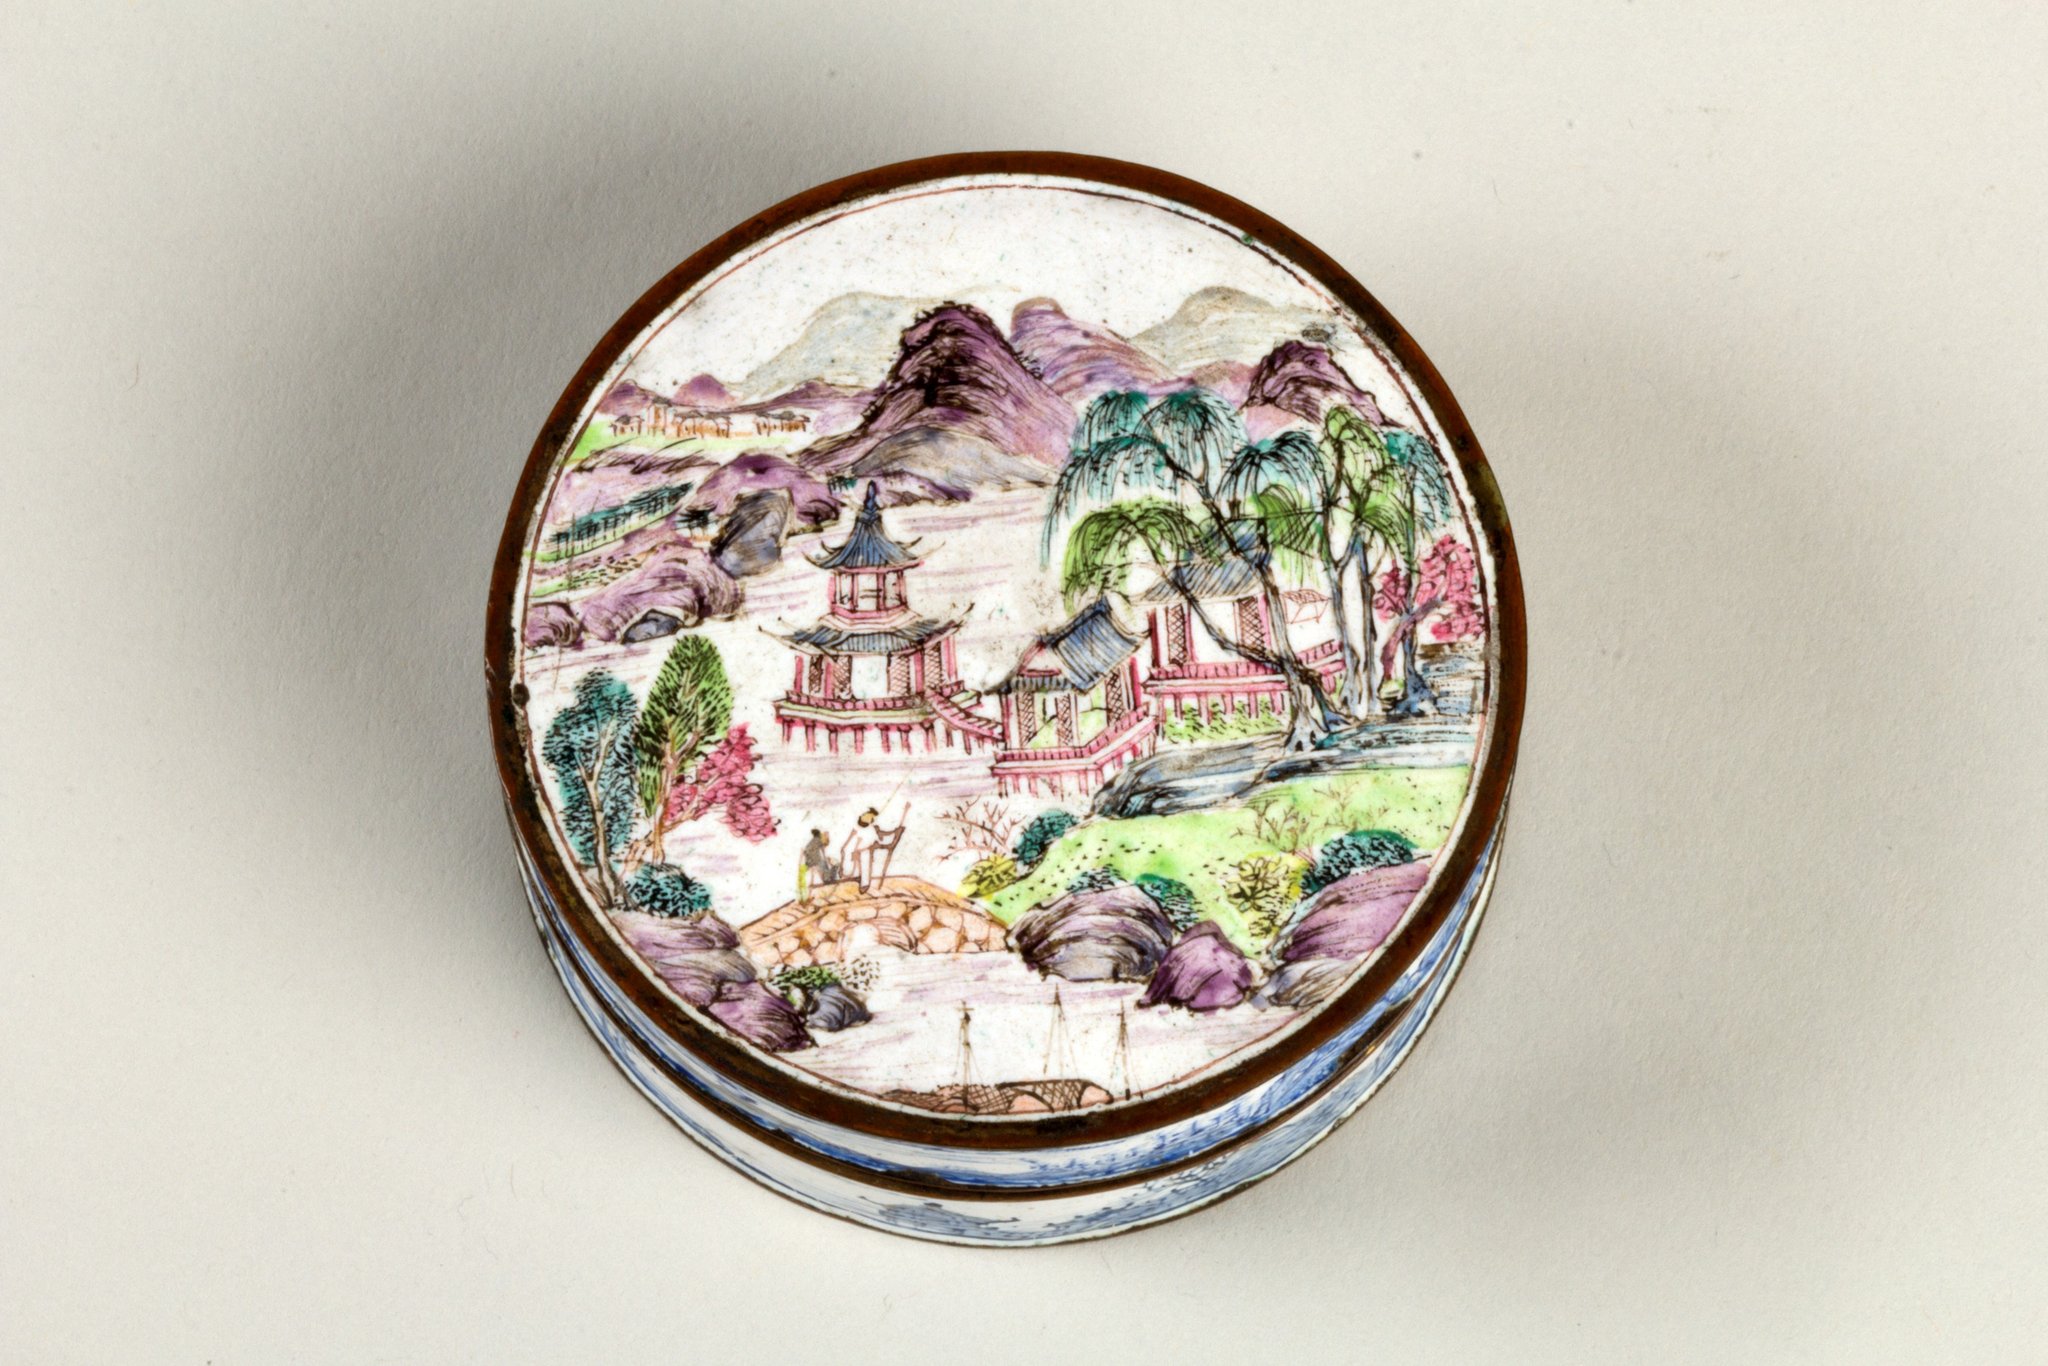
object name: covered box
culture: chinese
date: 1736-1795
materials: enamel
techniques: painting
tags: human figures,buildings,bridges,hills,trees